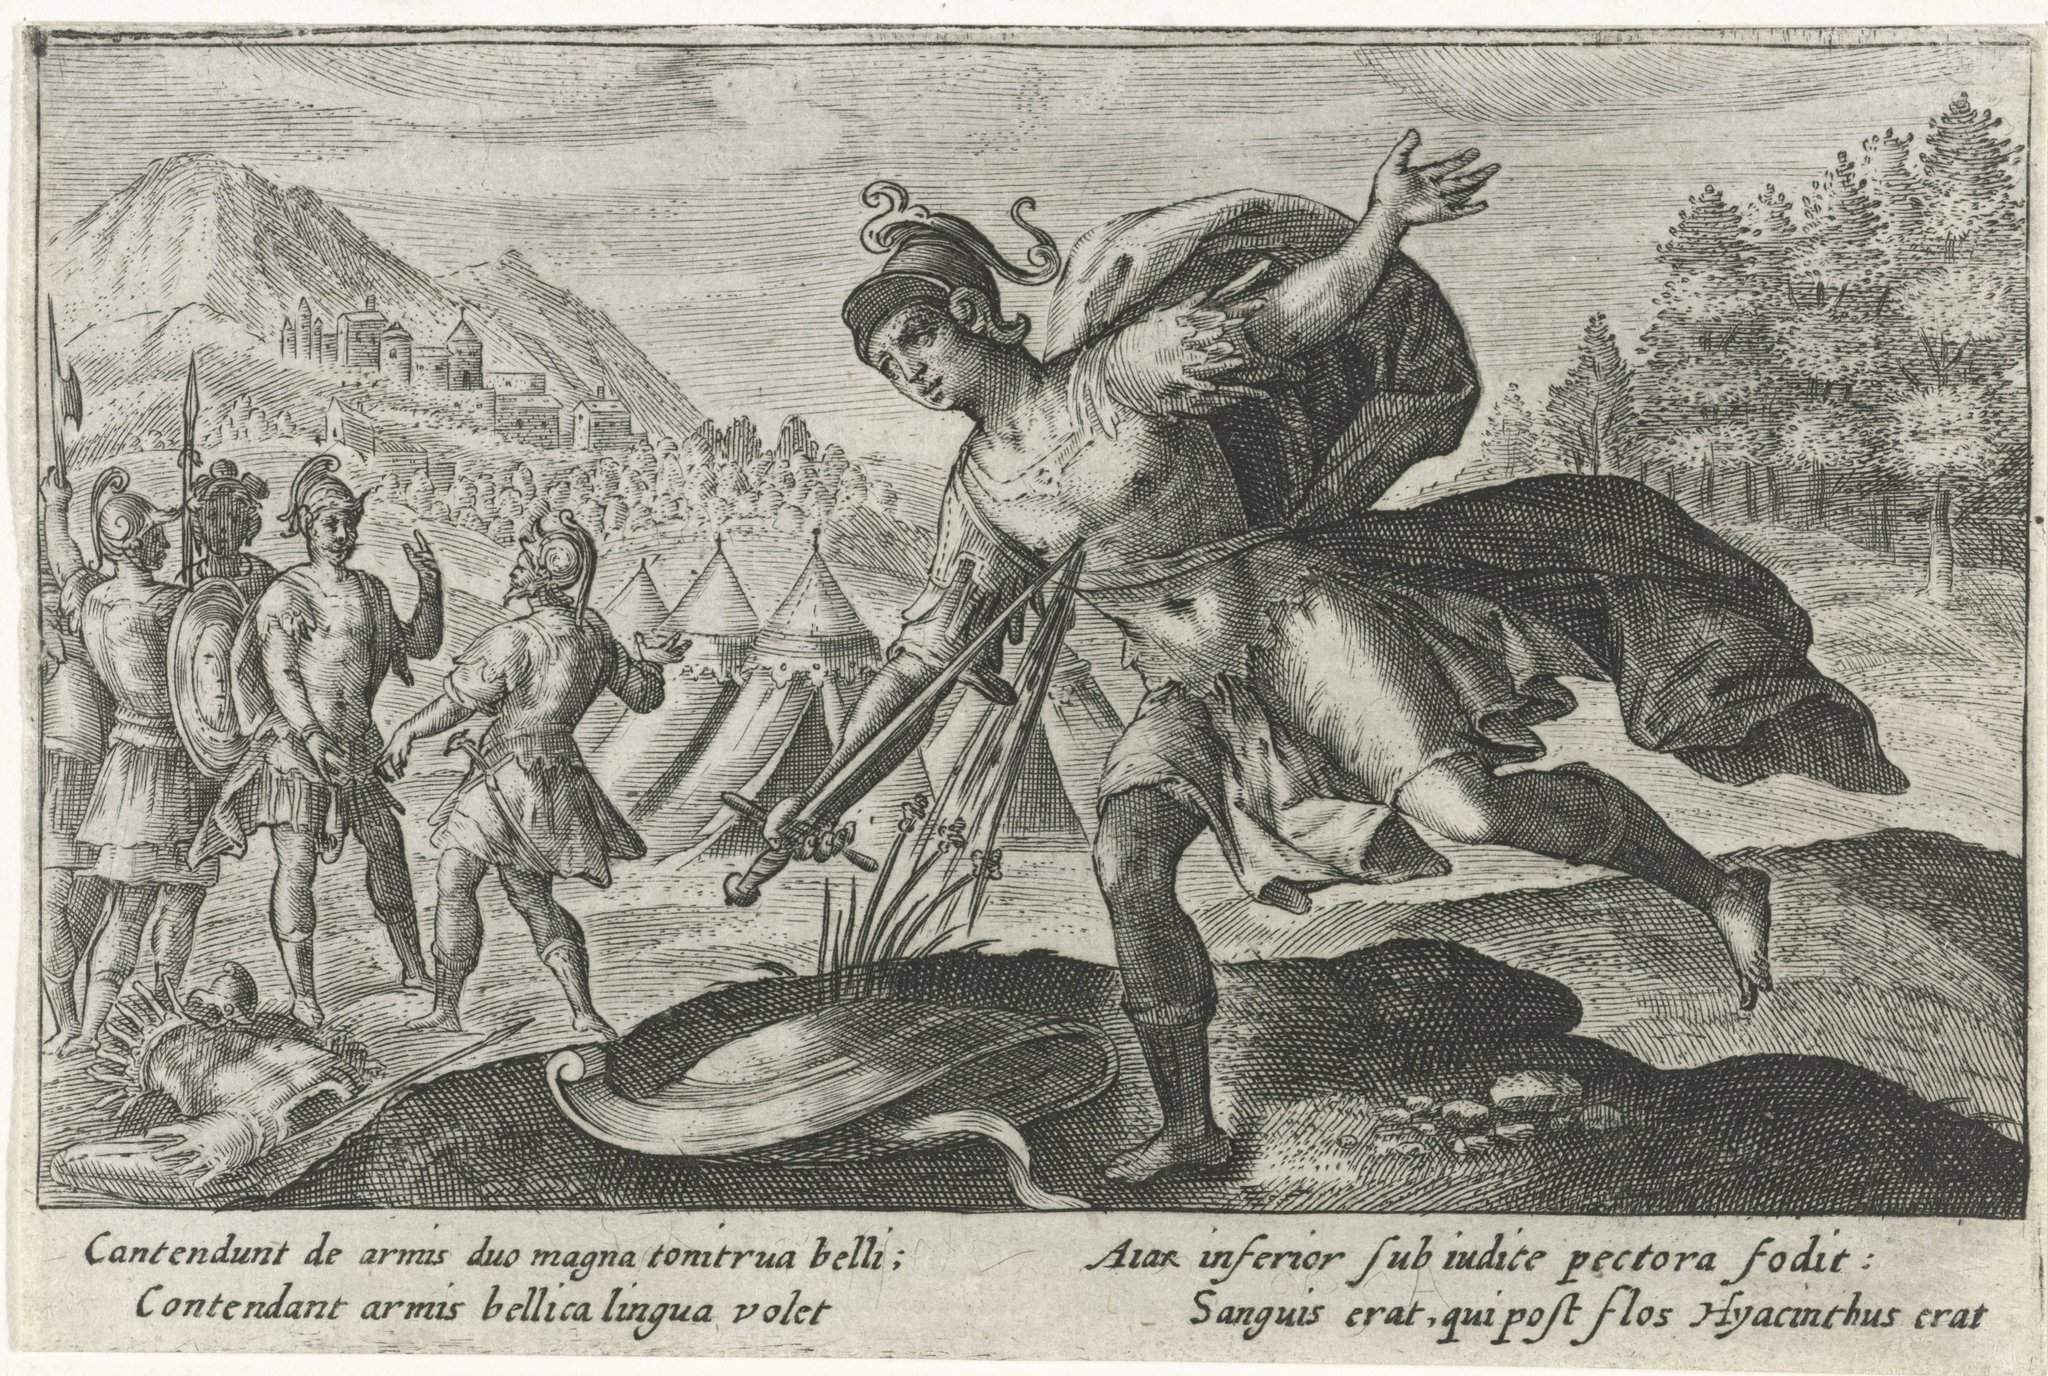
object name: print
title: Metamorfosen van Ovidius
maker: crispijn van de passe (i)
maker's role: draughtsman, print maker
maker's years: 1564-1637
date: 1602-1607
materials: paper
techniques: engraving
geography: cologne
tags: fight between ulysses and ajax the great for achilles' arms, ajax' blood changed into a hyacinth: after ajax has taken his own life, his blood is changed into a hyacinth (ovid, metamorphoses x 207; xiii 390), suicide of ajax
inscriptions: collector's mark: Lugt 2228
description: Nadat Ajax de strijd om de wapens van Achilles heeft verloren stort hij zich in zijn eigen zwaard. Waar zijn bloed op de grond valt bloeien hyacinten. In de marge een vierregelig onderschrift, in twee kolommen, in het Latijn.